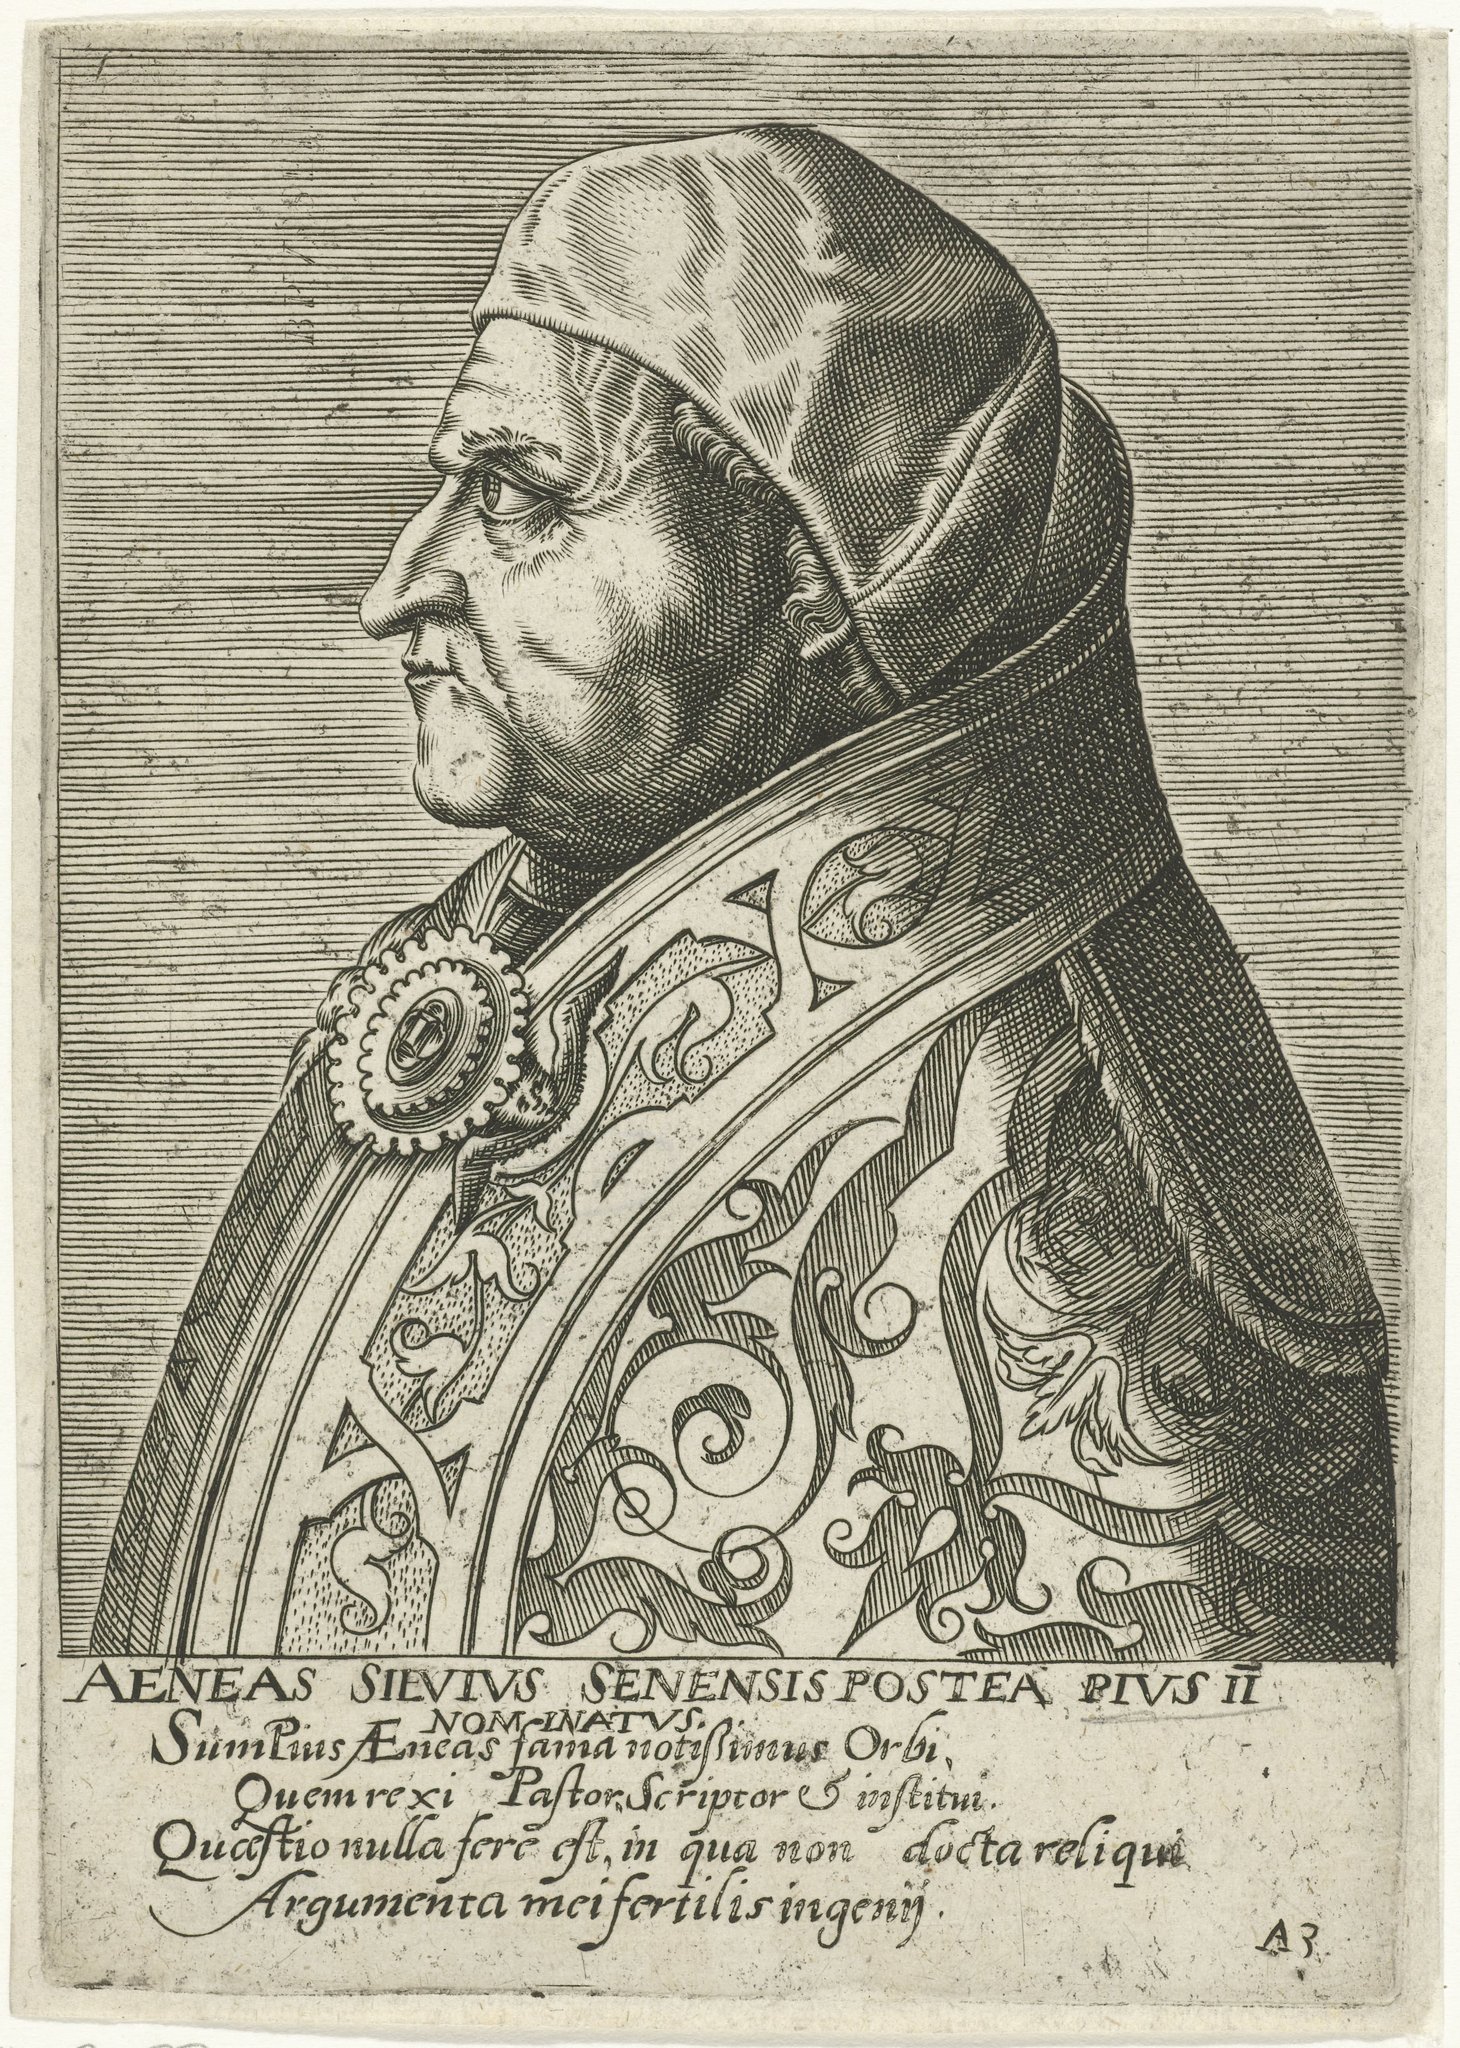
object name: print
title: Aeneas Sievivs Senensis postea Pivs II Nominantvs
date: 1567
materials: paper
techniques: engraving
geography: antwerp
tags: rome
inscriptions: collector's mark: Lugt 2228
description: Portret van paus Pius II. In profiel naar links. Genummerd A3. De prent heeft een Latijns onderschrift en maakt deel uit van een serie van beroemde Europese geleerden.